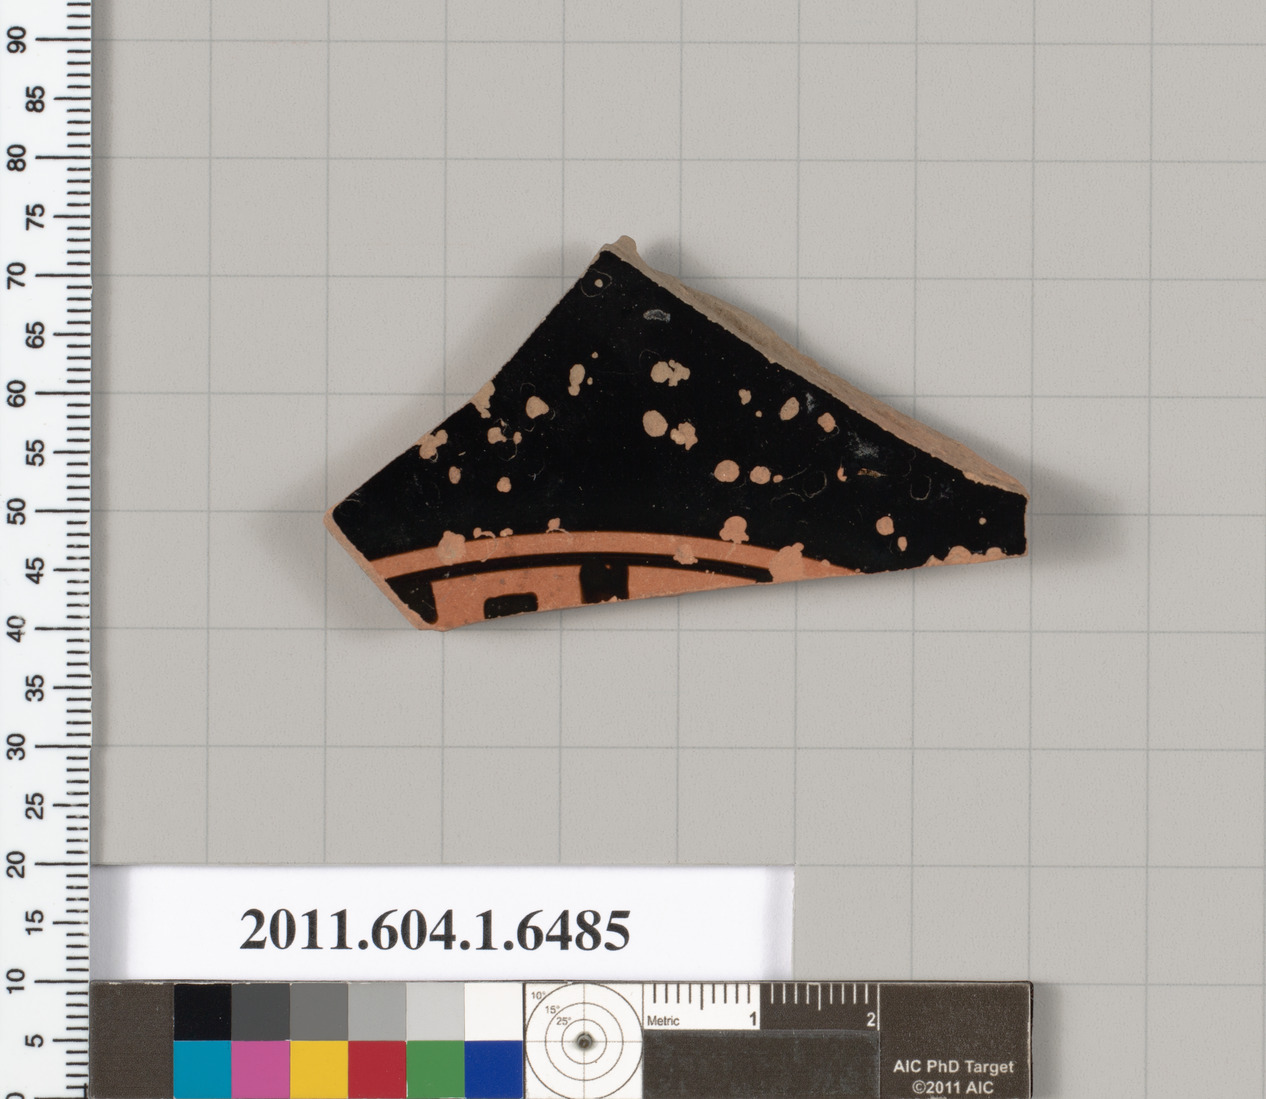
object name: kylix fragment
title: Terracotta fragment of a kylix (drinking cup)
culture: greek, attic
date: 490-480 BCE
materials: terracotta